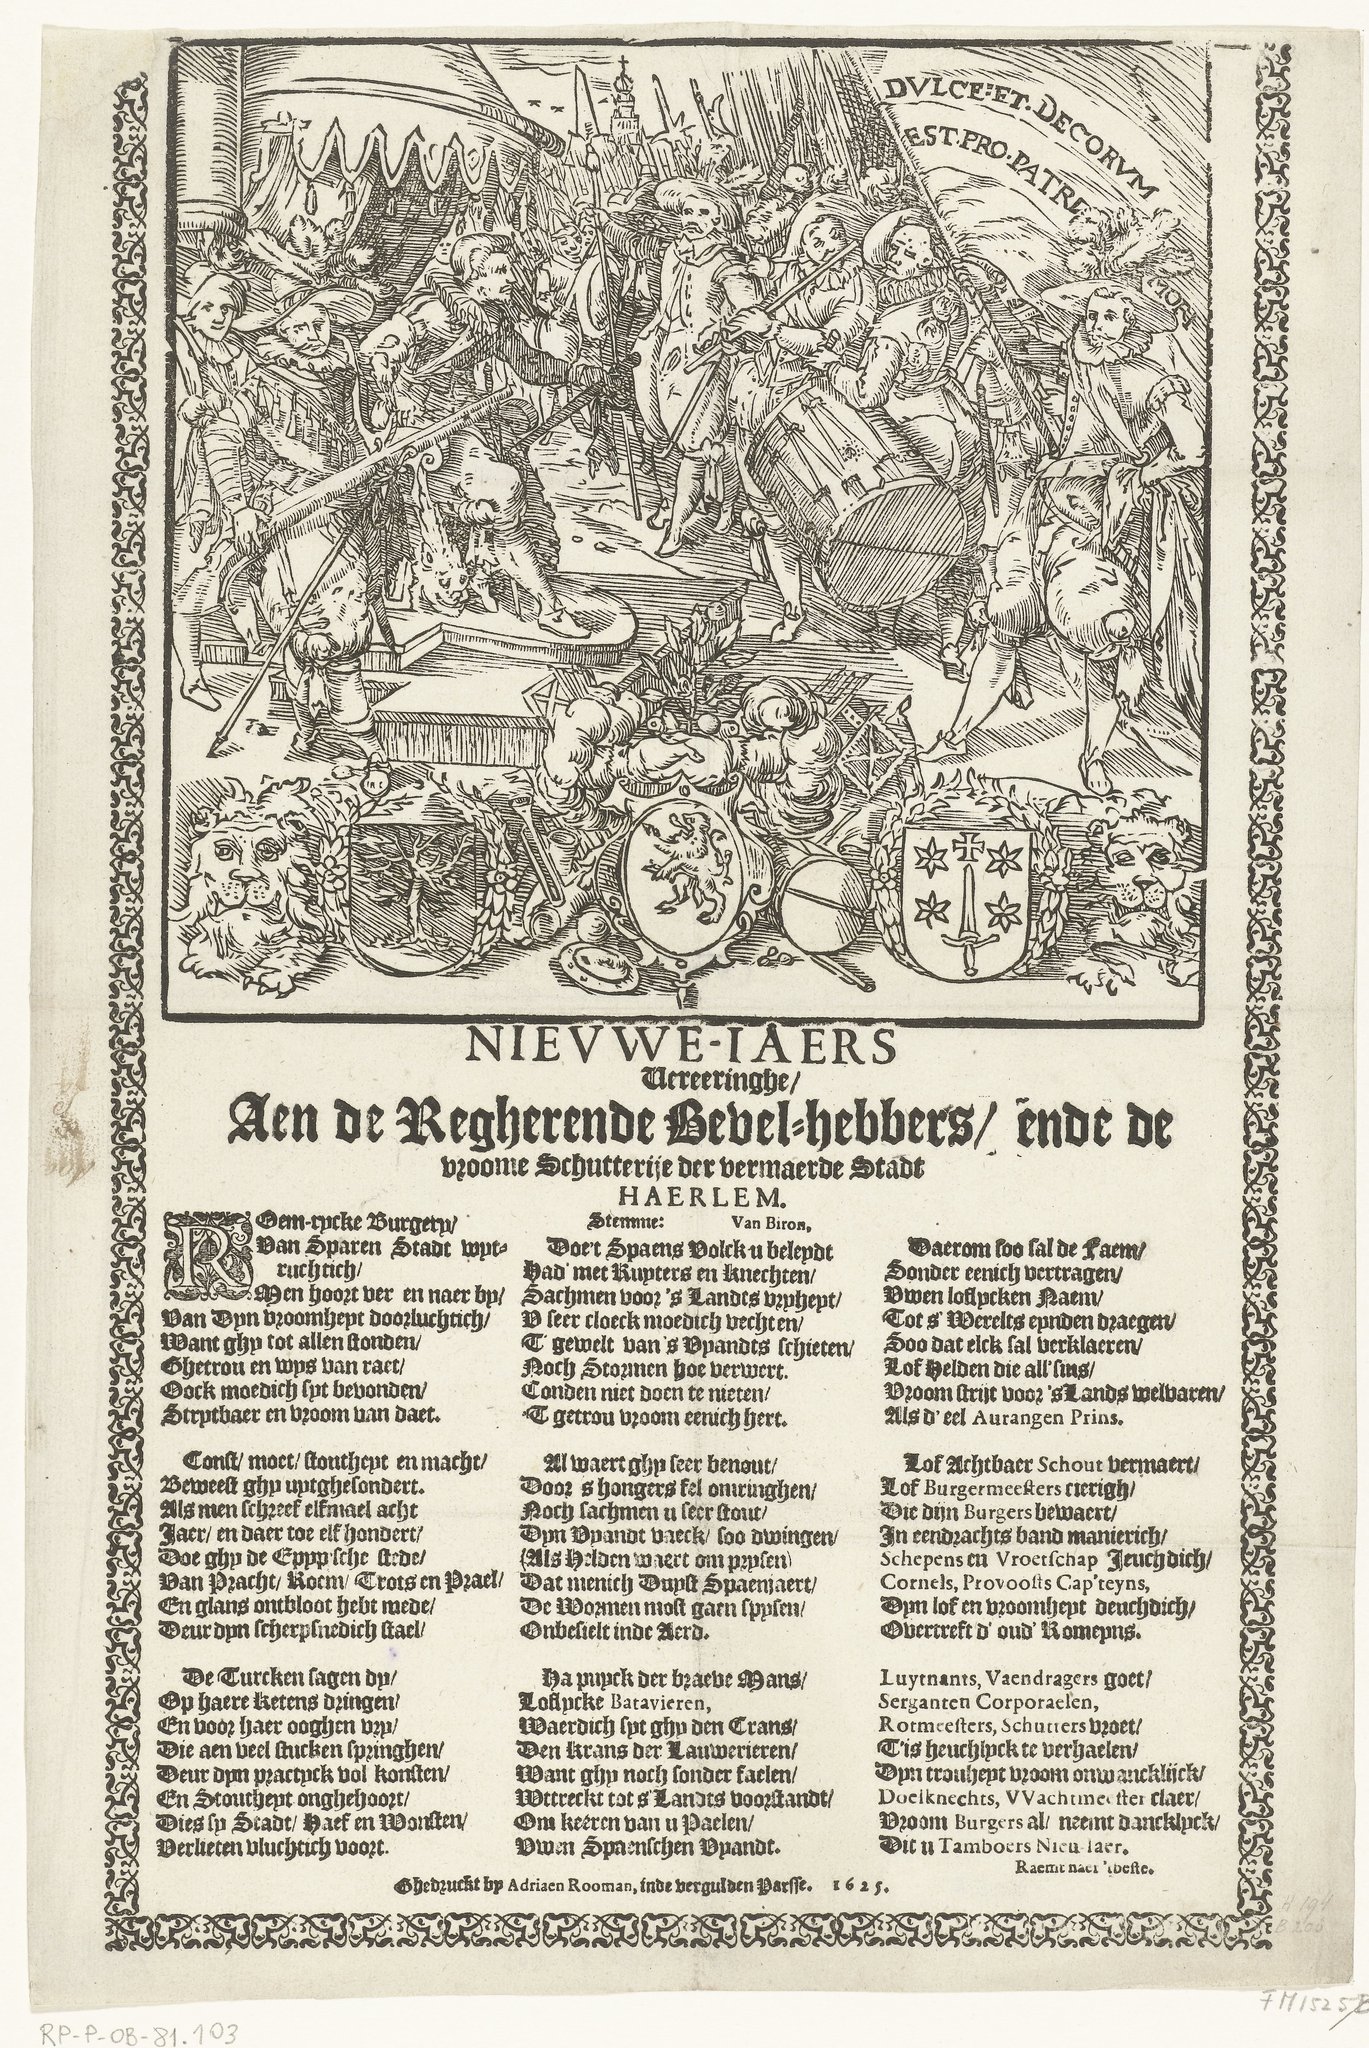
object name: print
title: Nieuwjaarsprent van de Haarlemse schutterij, 1625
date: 1625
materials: paper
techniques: letterpress printing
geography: haarlem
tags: the hague, maurice (prince of orange), warfare; military affairs (+ citizen soldiery, civil guard, citizen militia), haarlem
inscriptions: date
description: Nieuwjaarsprent van de Haarlemse schutterij, 1625. Links Maurits gezeten op zijn troon, voor hem staan de schutters, met vooraan de vaandrig, trommelslager en pijper. Op de voorgrond de wapens van Haarlem en Holland. Op de achtergrond de toren van de Sint-Bavo te Haarlem. Onder de voorstelling 9 verzen in het Nederlands.